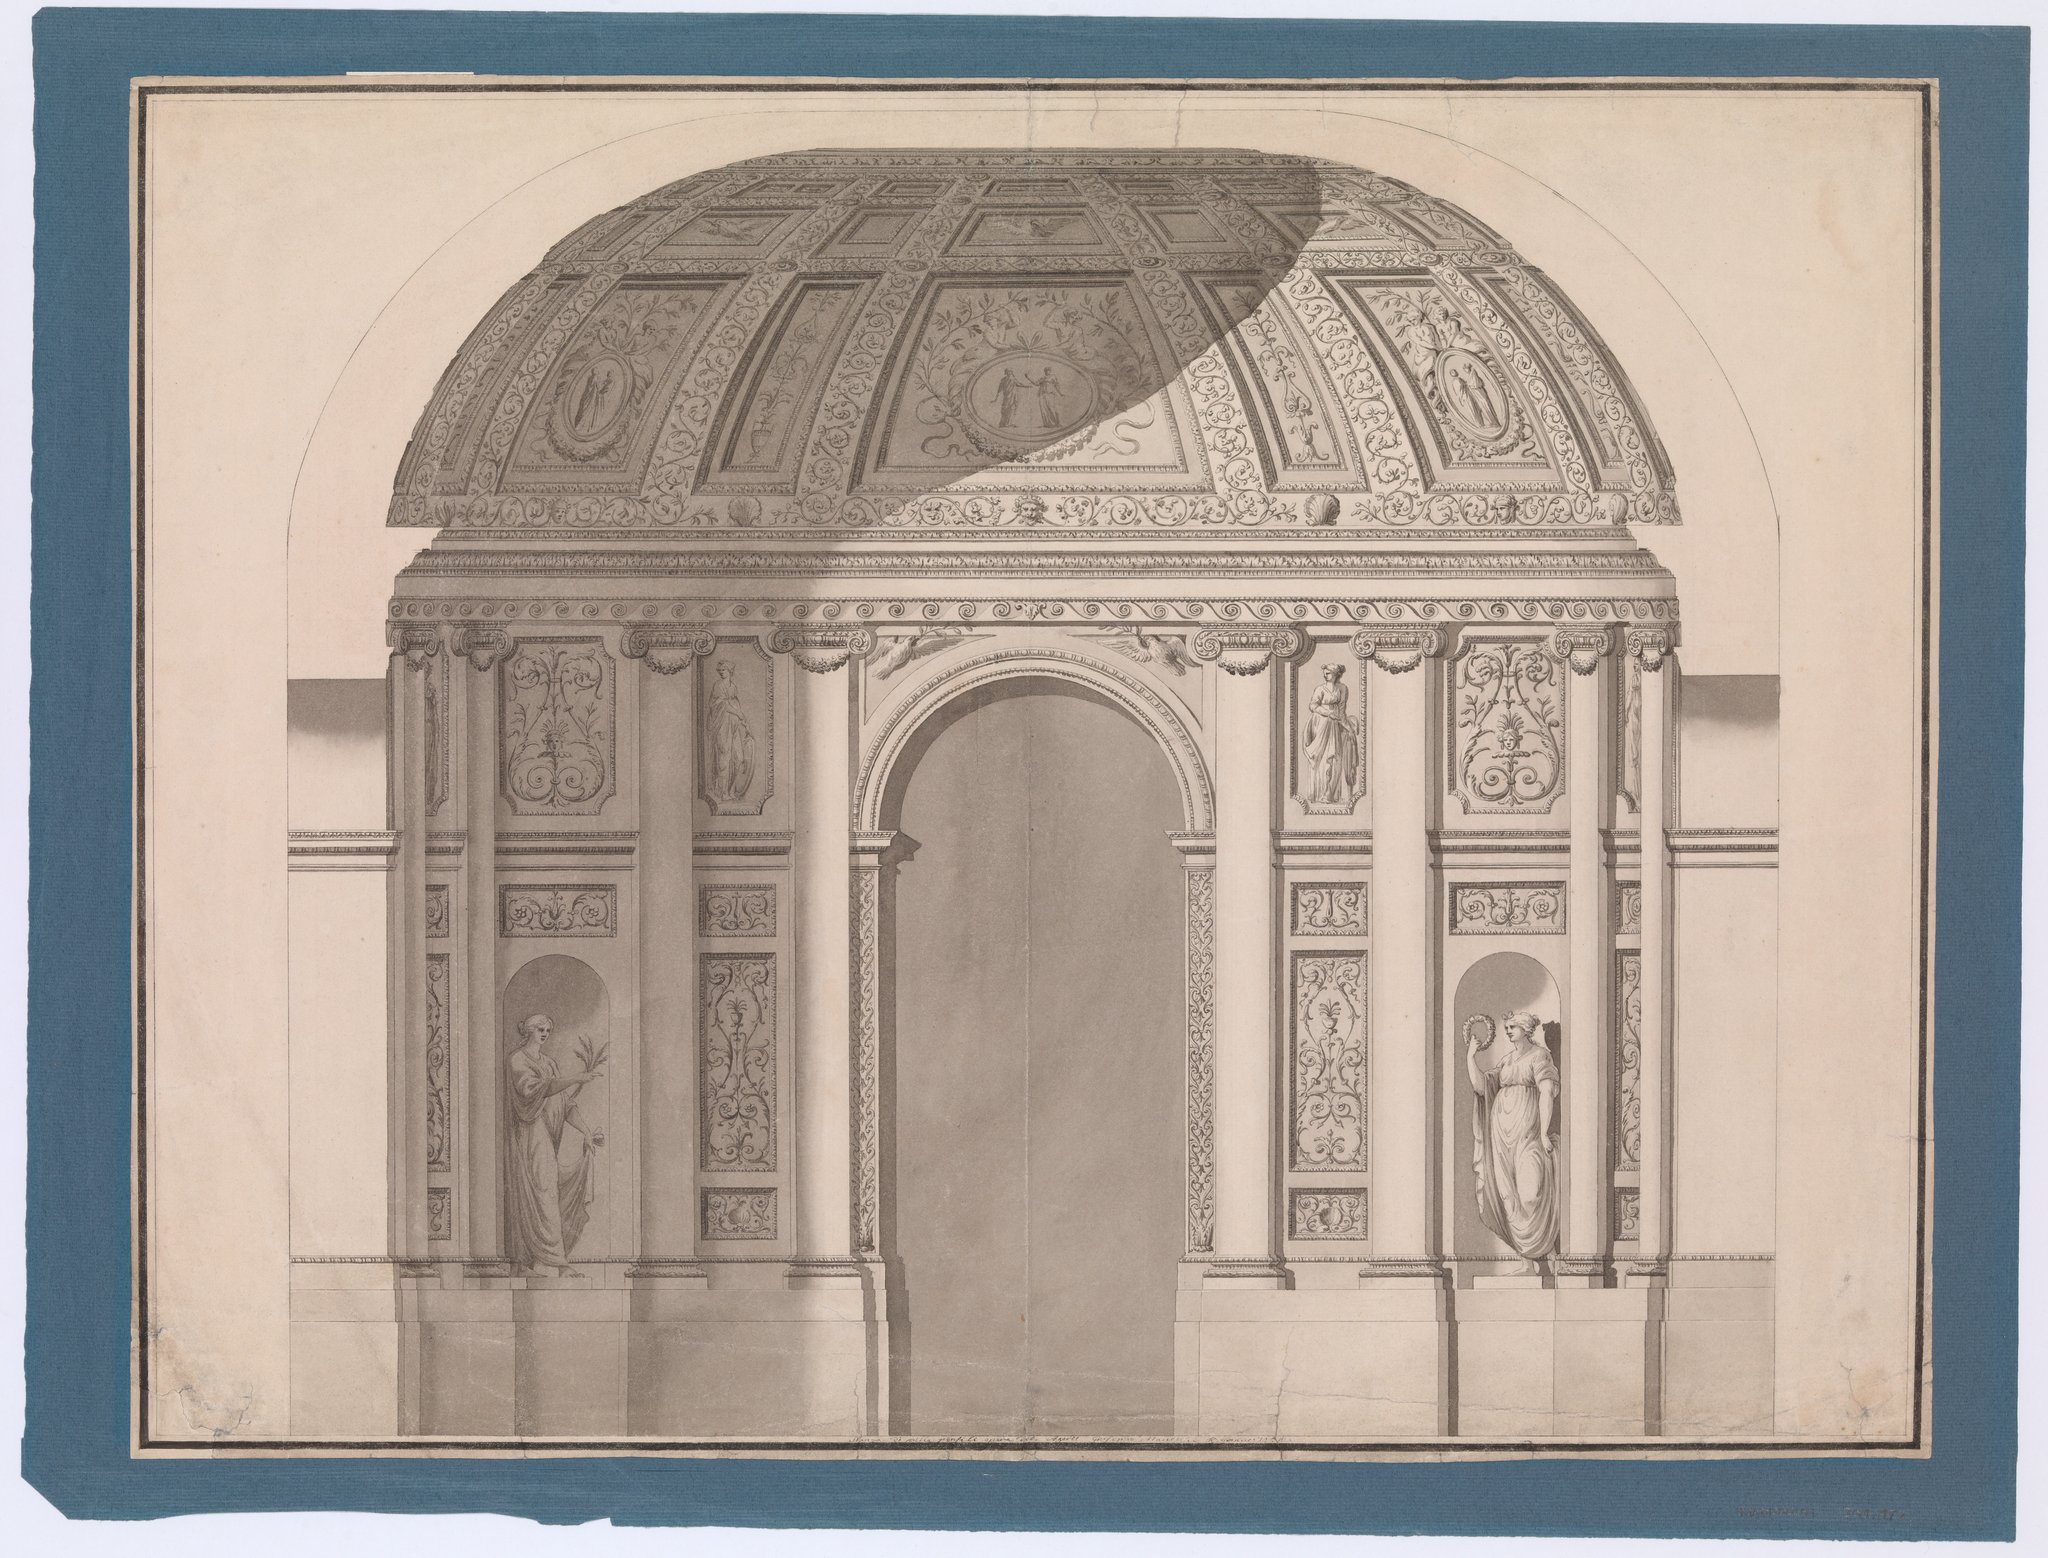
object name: drawing ornament architecture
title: Section of the Sala Pianterreno by Algardi in the Villa Doria Pamphili, Rome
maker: guiseppe mannocchi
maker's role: artist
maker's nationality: italian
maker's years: 1731-1782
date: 1744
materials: ink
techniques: pen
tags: architecture